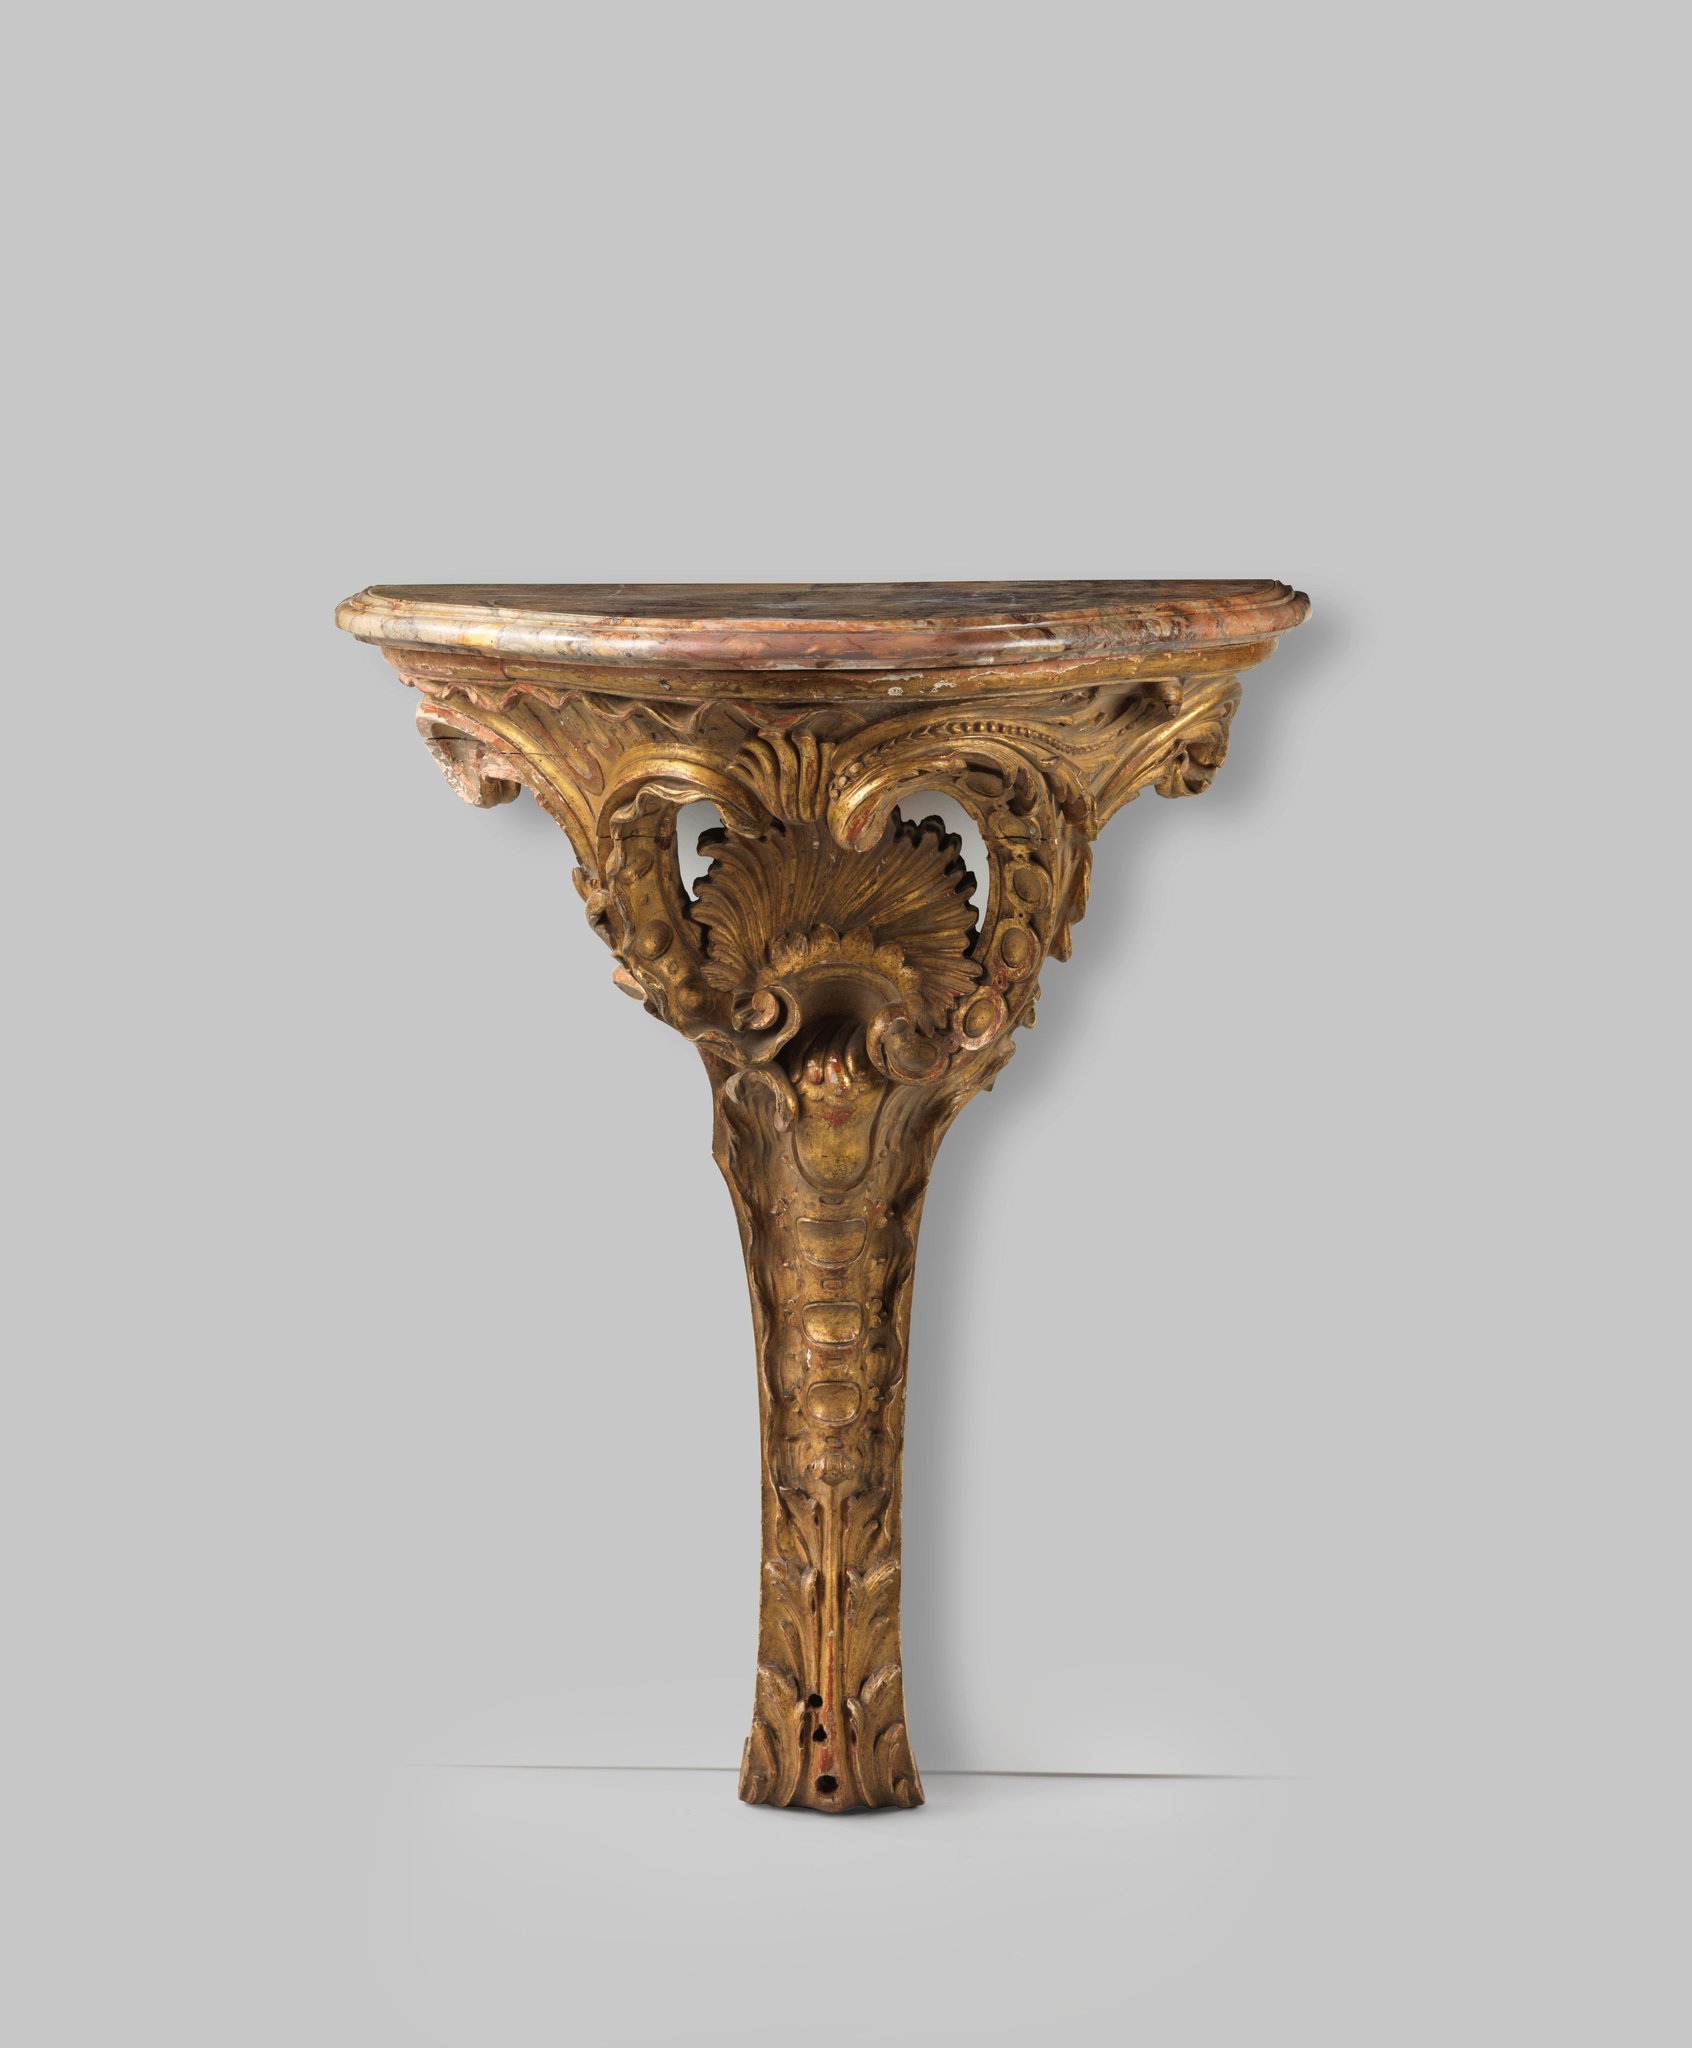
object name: tabletop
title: Tafelblad van marmer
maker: Anonymous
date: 1750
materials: marble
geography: germany